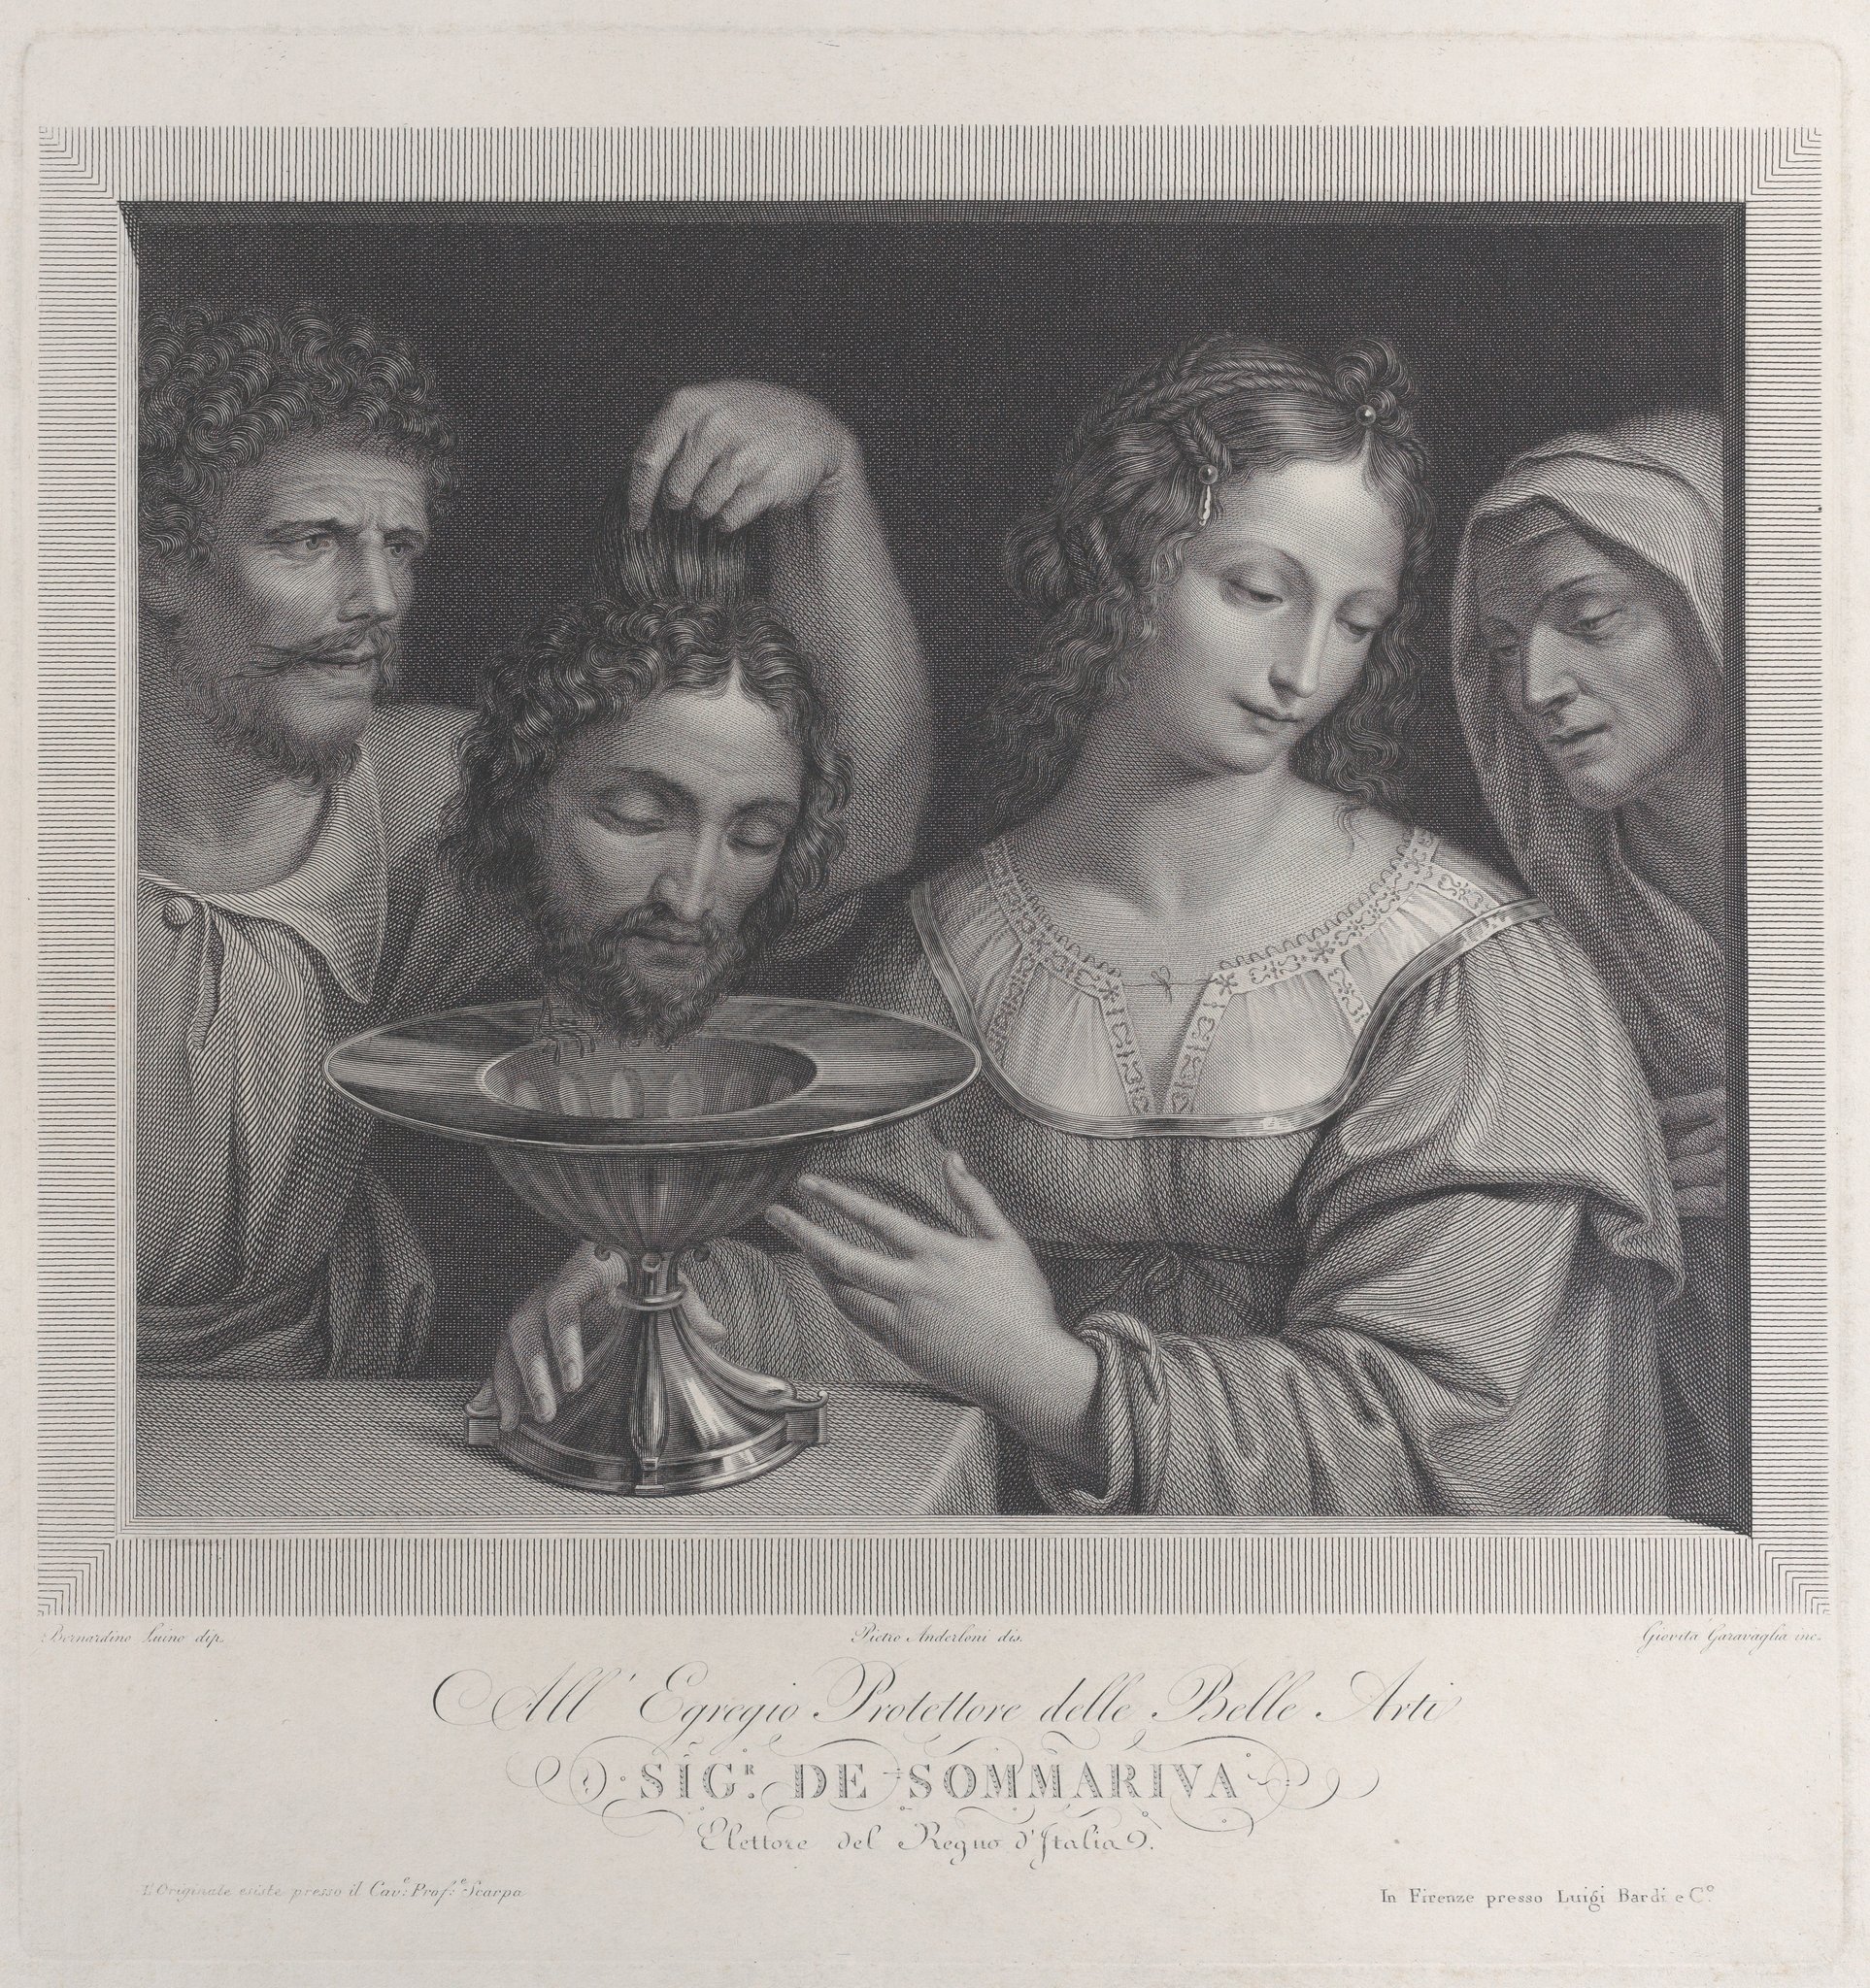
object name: print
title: Salome and the head of Saint John the Baptist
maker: giovita garavaglia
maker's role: artist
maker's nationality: italian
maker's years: 1790-1835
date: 1815-1835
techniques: engraving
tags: saint john the baptist,salome